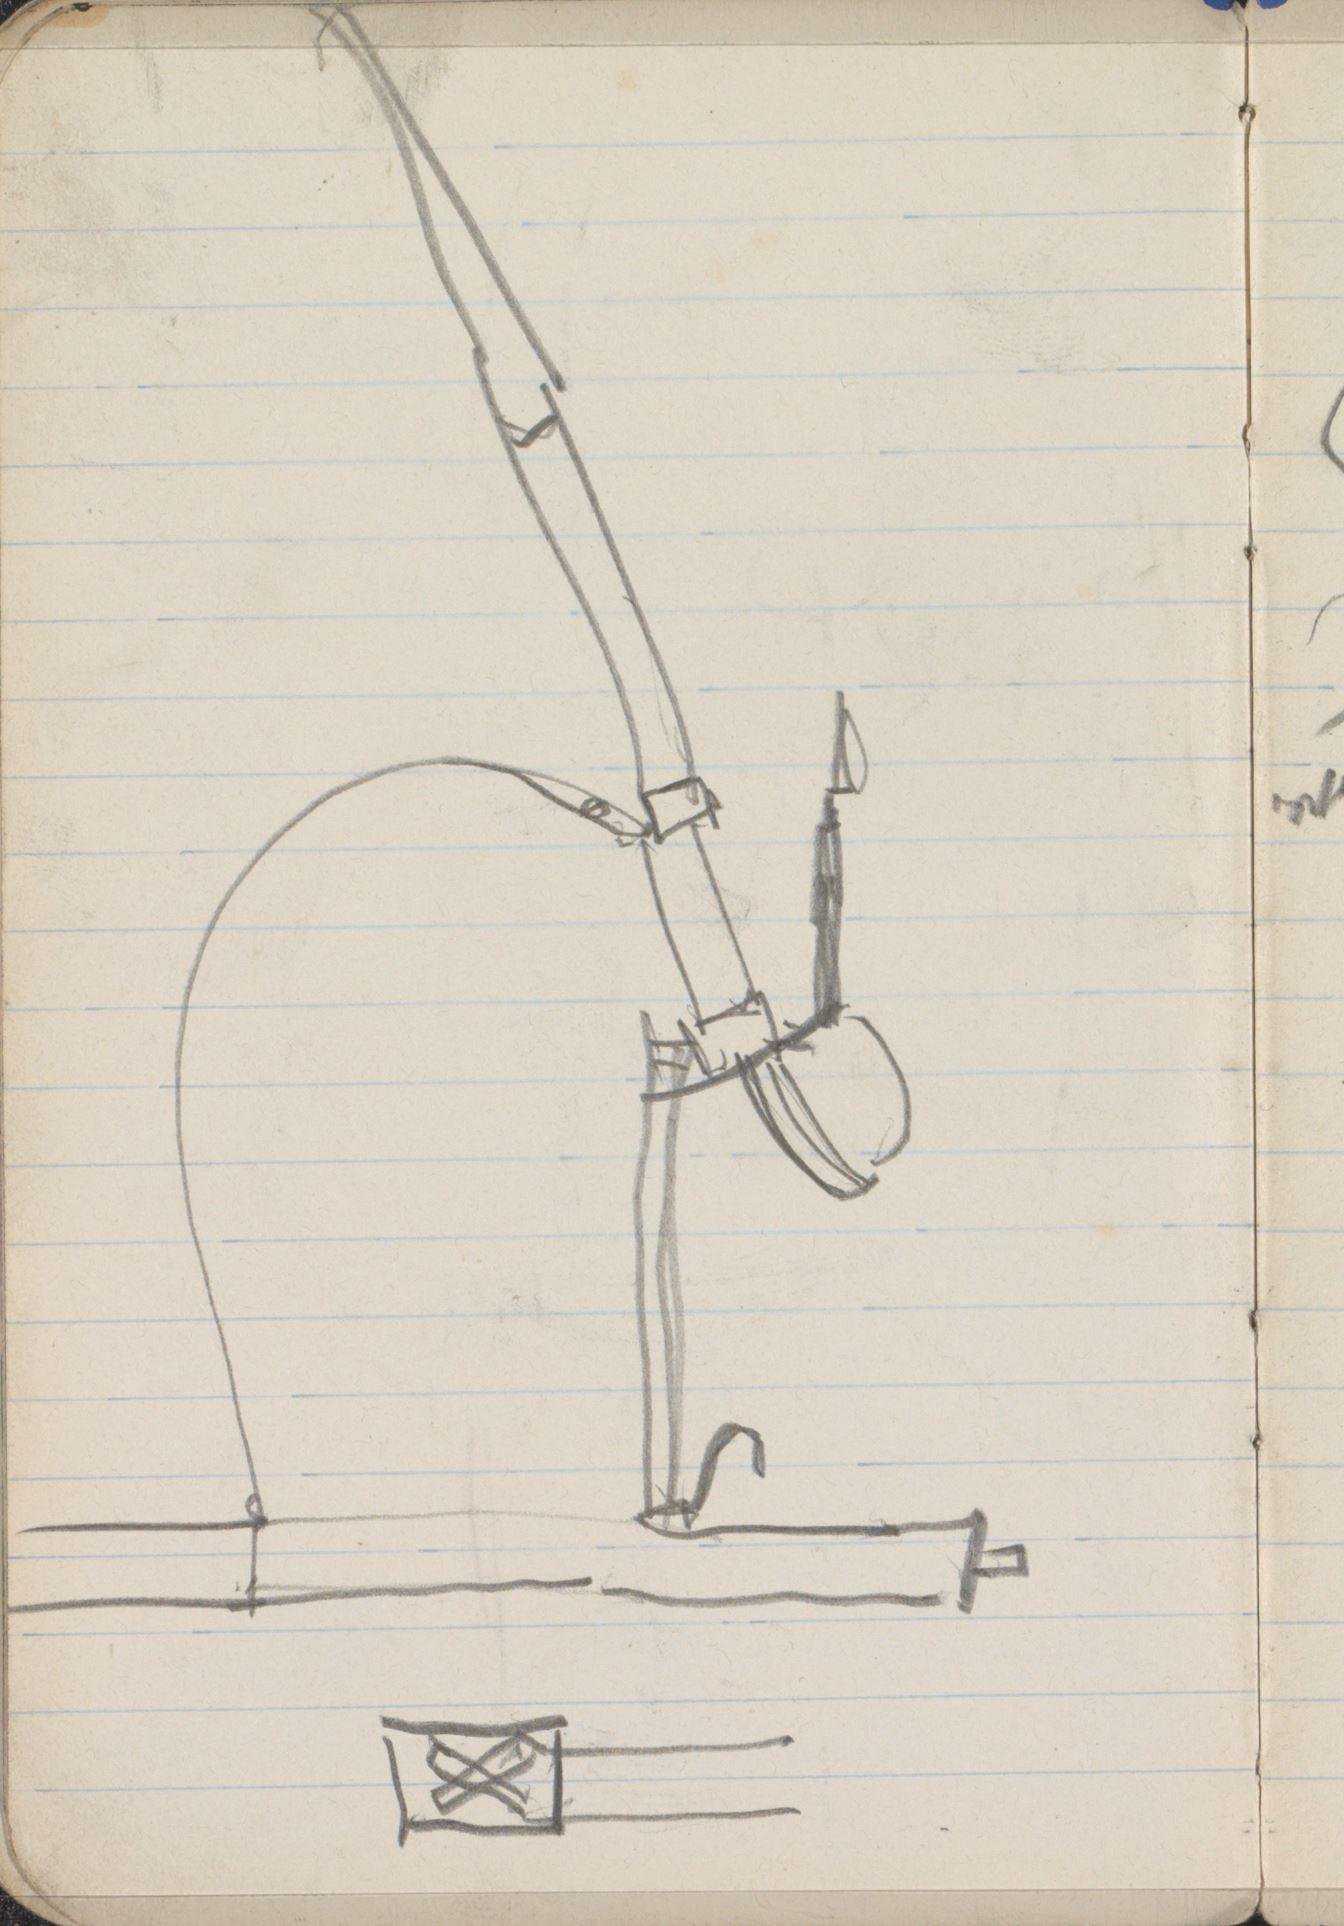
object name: sketchbook leaf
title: Studies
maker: george hendrik breitner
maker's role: draughtsman, painter, print maker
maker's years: 1857-1923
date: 1898-1902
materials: pencil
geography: amsterdam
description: Pagina 31 uit een schetsboek met 42 bladen.